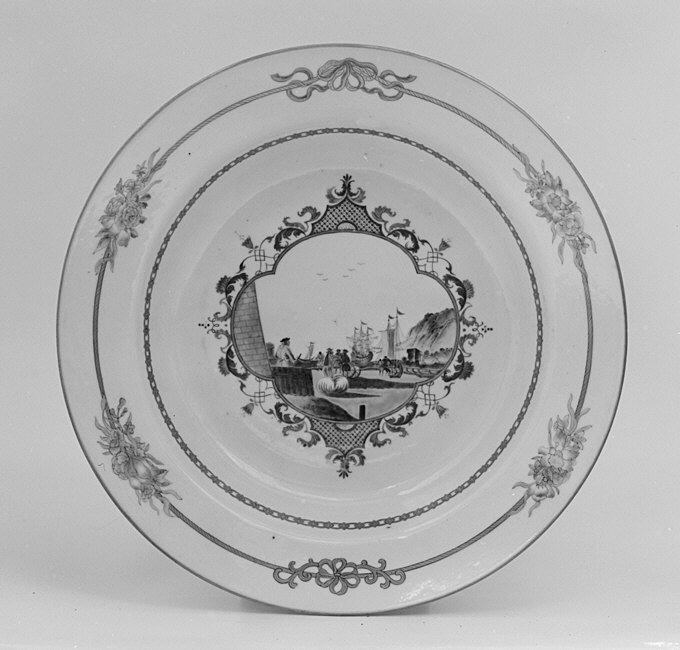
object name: soup plate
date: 1750-1770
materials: hard paste porcelain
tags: flowers,boats